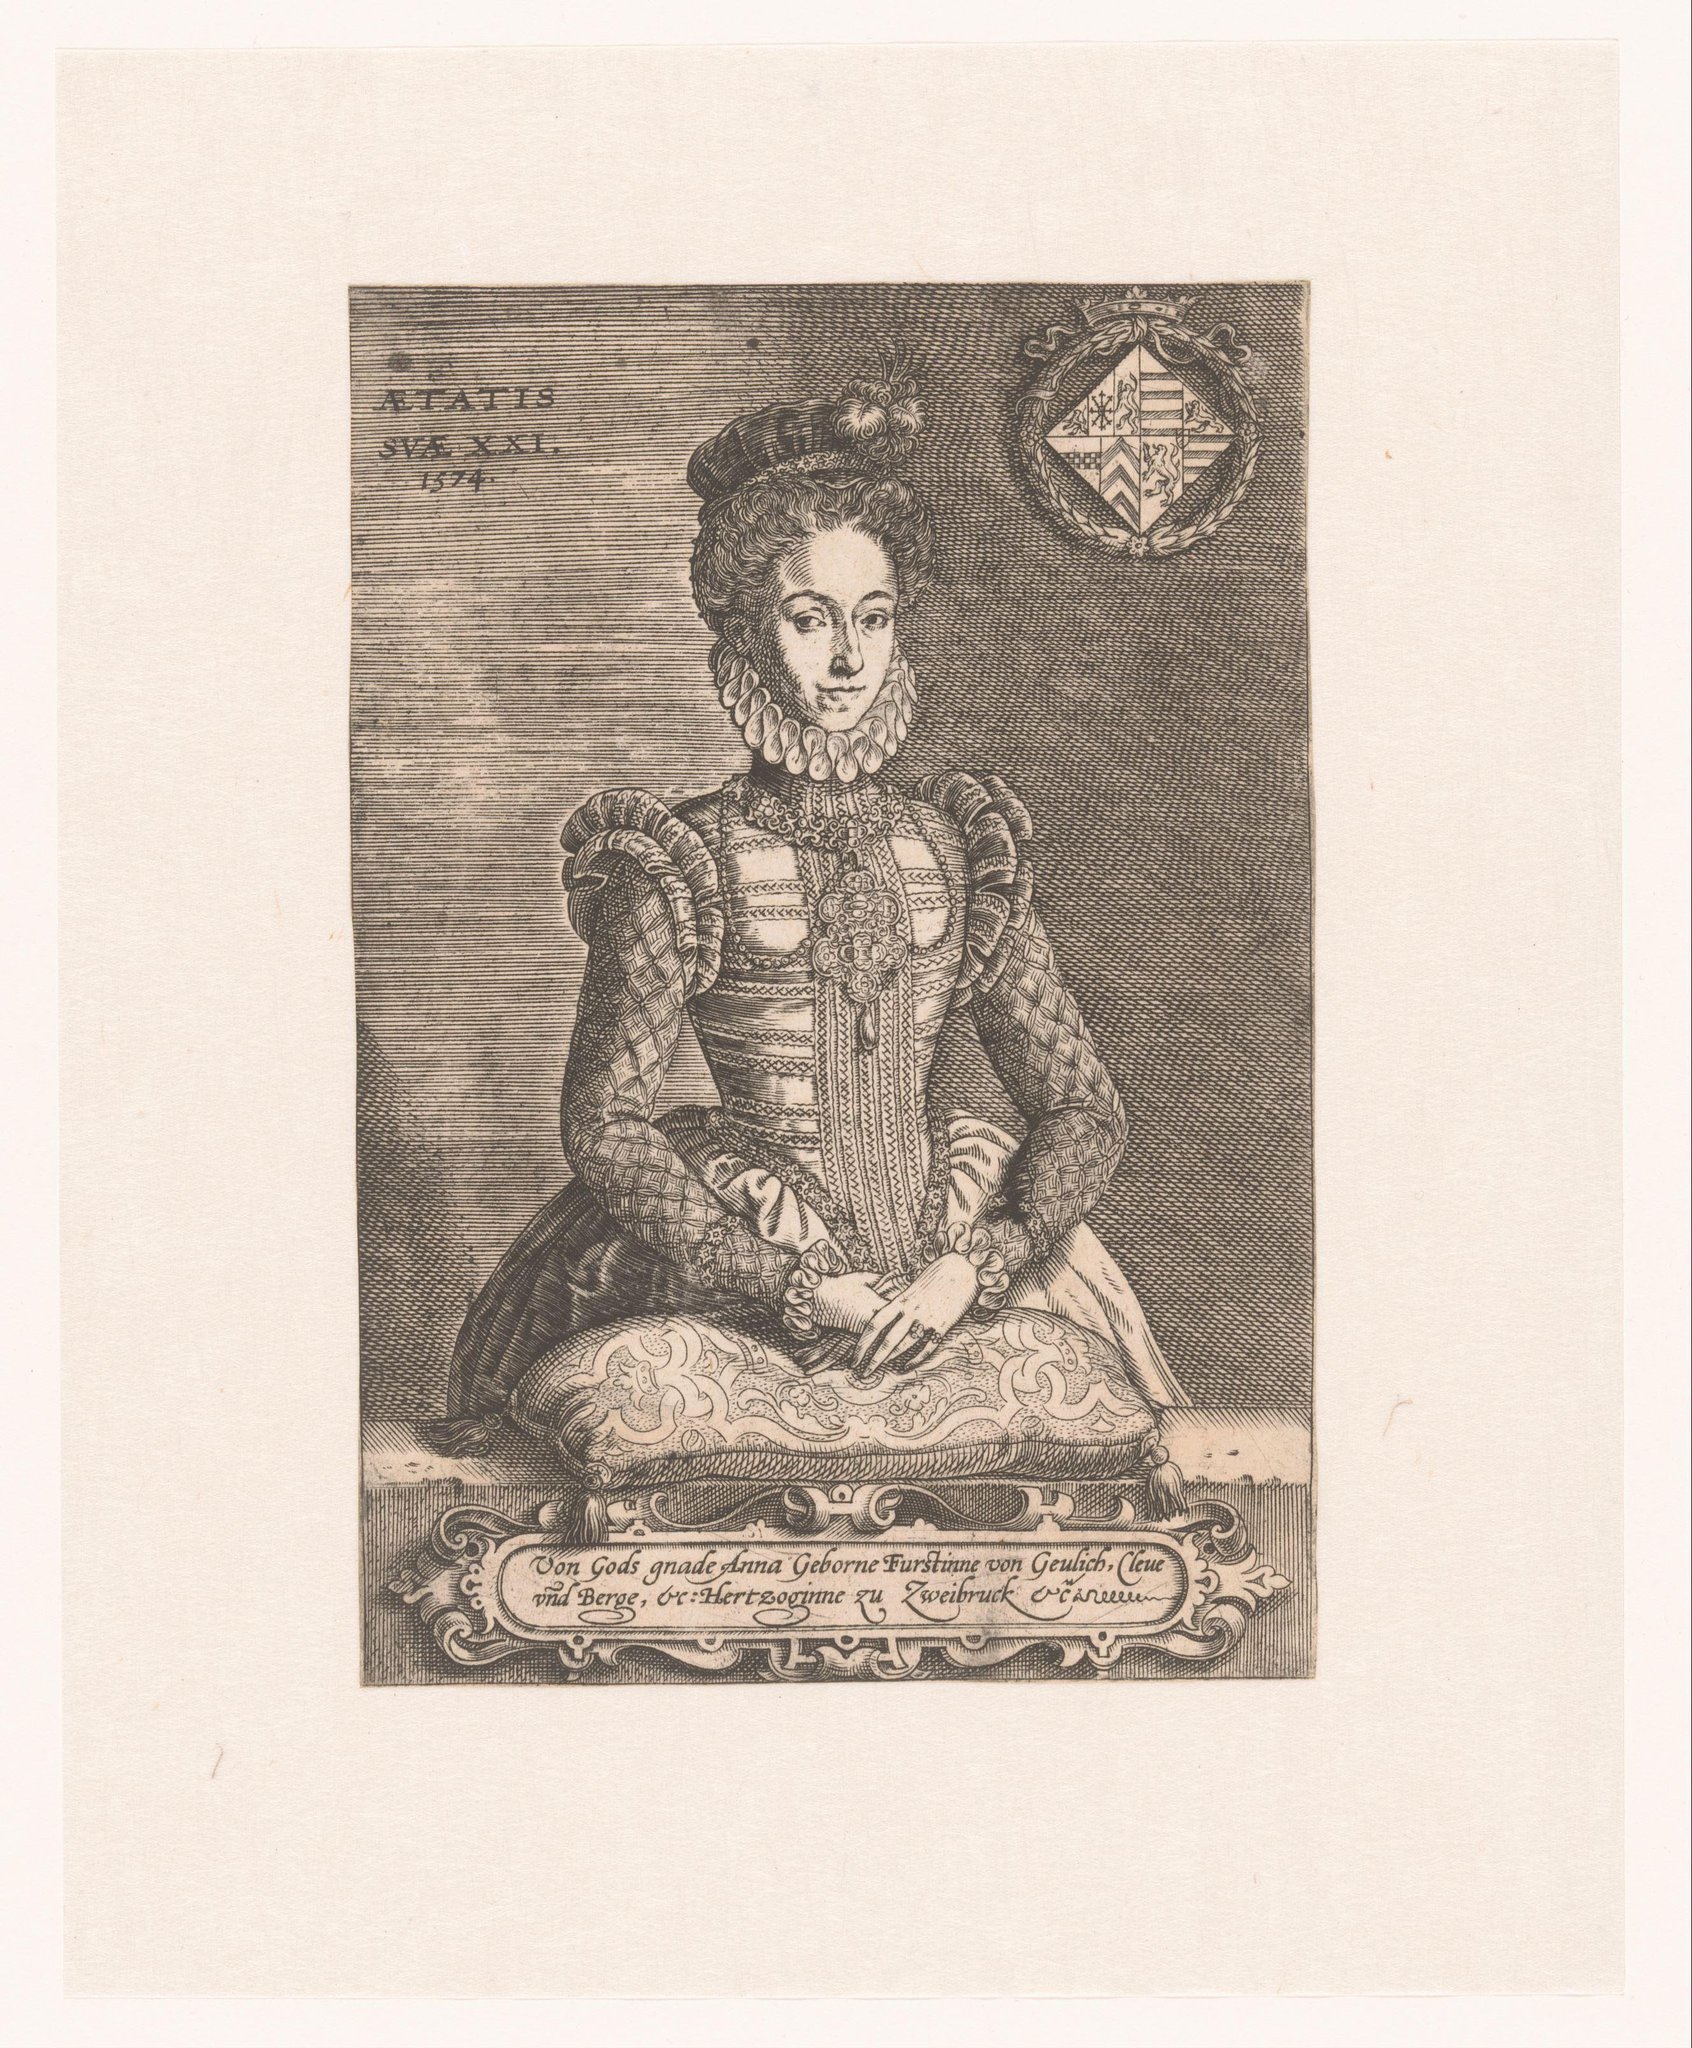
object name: print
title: Portret van Anna van Kleef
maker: Anonymous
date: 1574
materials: paper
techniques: etching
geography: germany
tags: cleves, historical persons, clothes, costume (+ women's clothes), head-gear: hat (+ women's clothes), neck-gear ~ clothing (with name) (+ women's clothes), dress, gown (+ women's clothes), pillow, sleeves (+ women's clothes), necklace (+ women's clothes), clothing for the upper part of the body (with name) (+ women's clothes), armorial bearing, heraldry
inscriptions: collector's mark: Lugt 2228, collector's mark: Lugt 2760